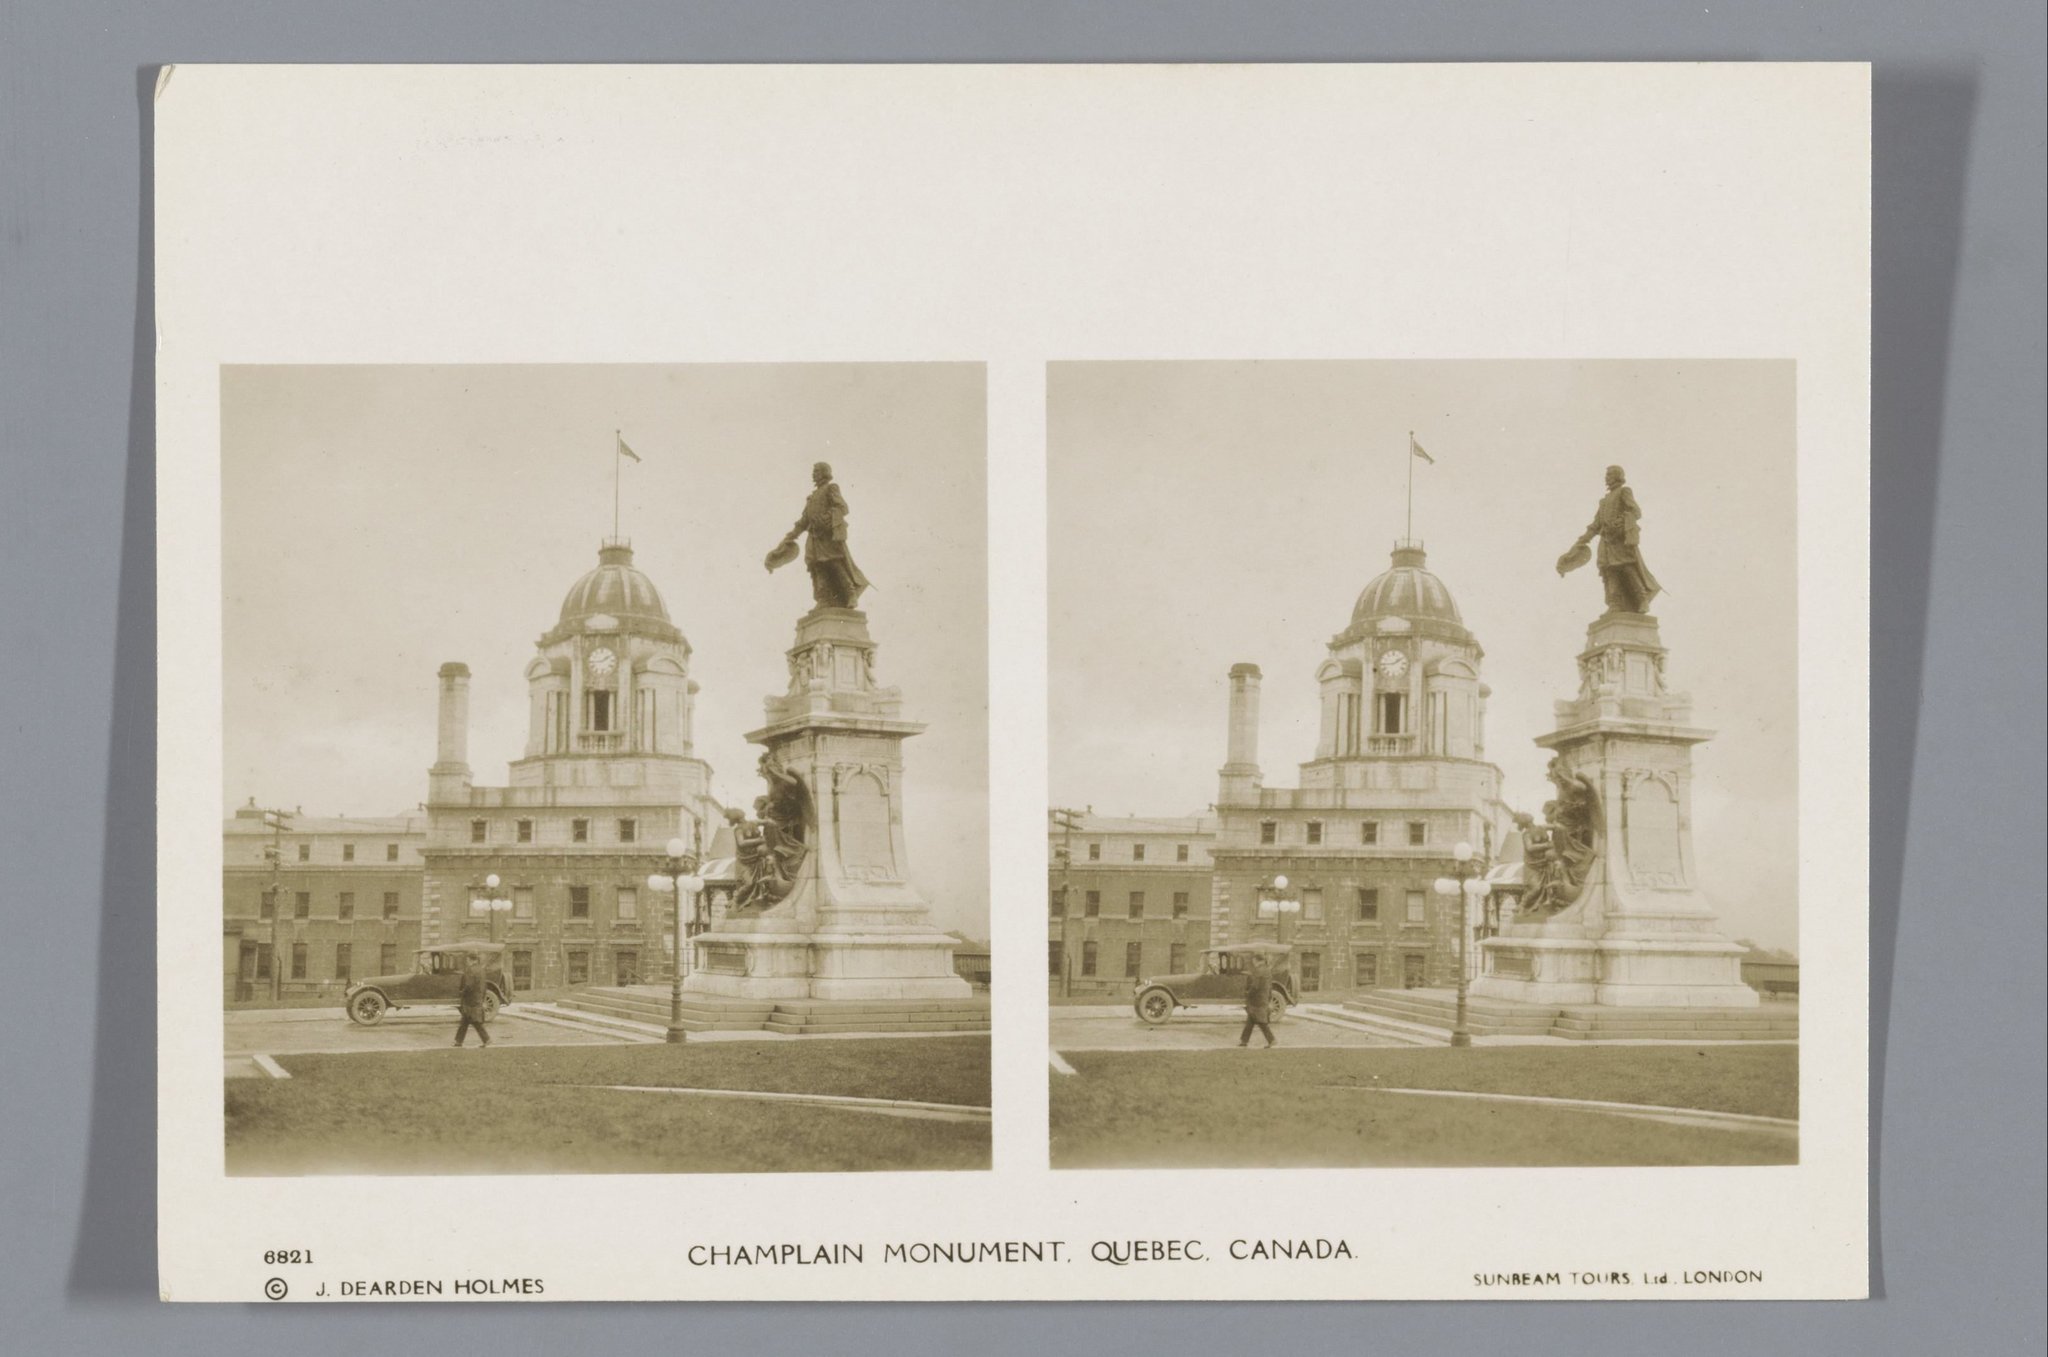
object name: stereograph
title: Monument voor Samuel de Champlain, Québec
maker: james dearden holmes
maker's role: fotograaf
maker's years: 1873-1937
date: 1924-1926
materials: paper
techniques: gelatin silver print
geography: london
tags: monument, statue, québec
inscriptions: number: ‘6821’